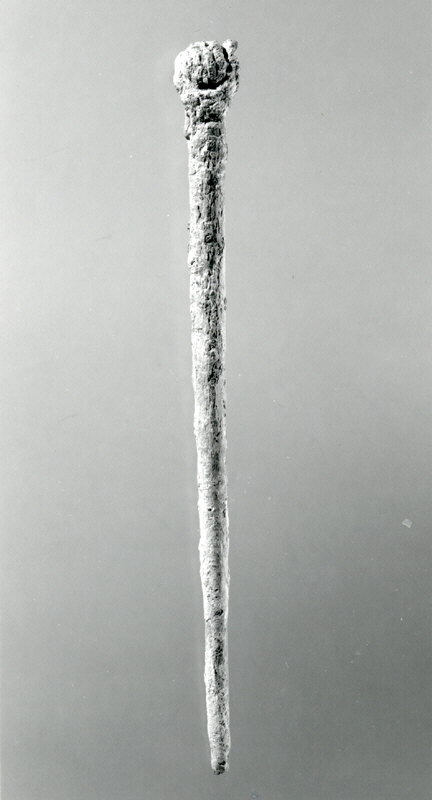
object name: pin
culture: bactria-margiana archaeological complex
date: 2333-1668 BCE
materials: copper alloy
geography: bactria-margiana